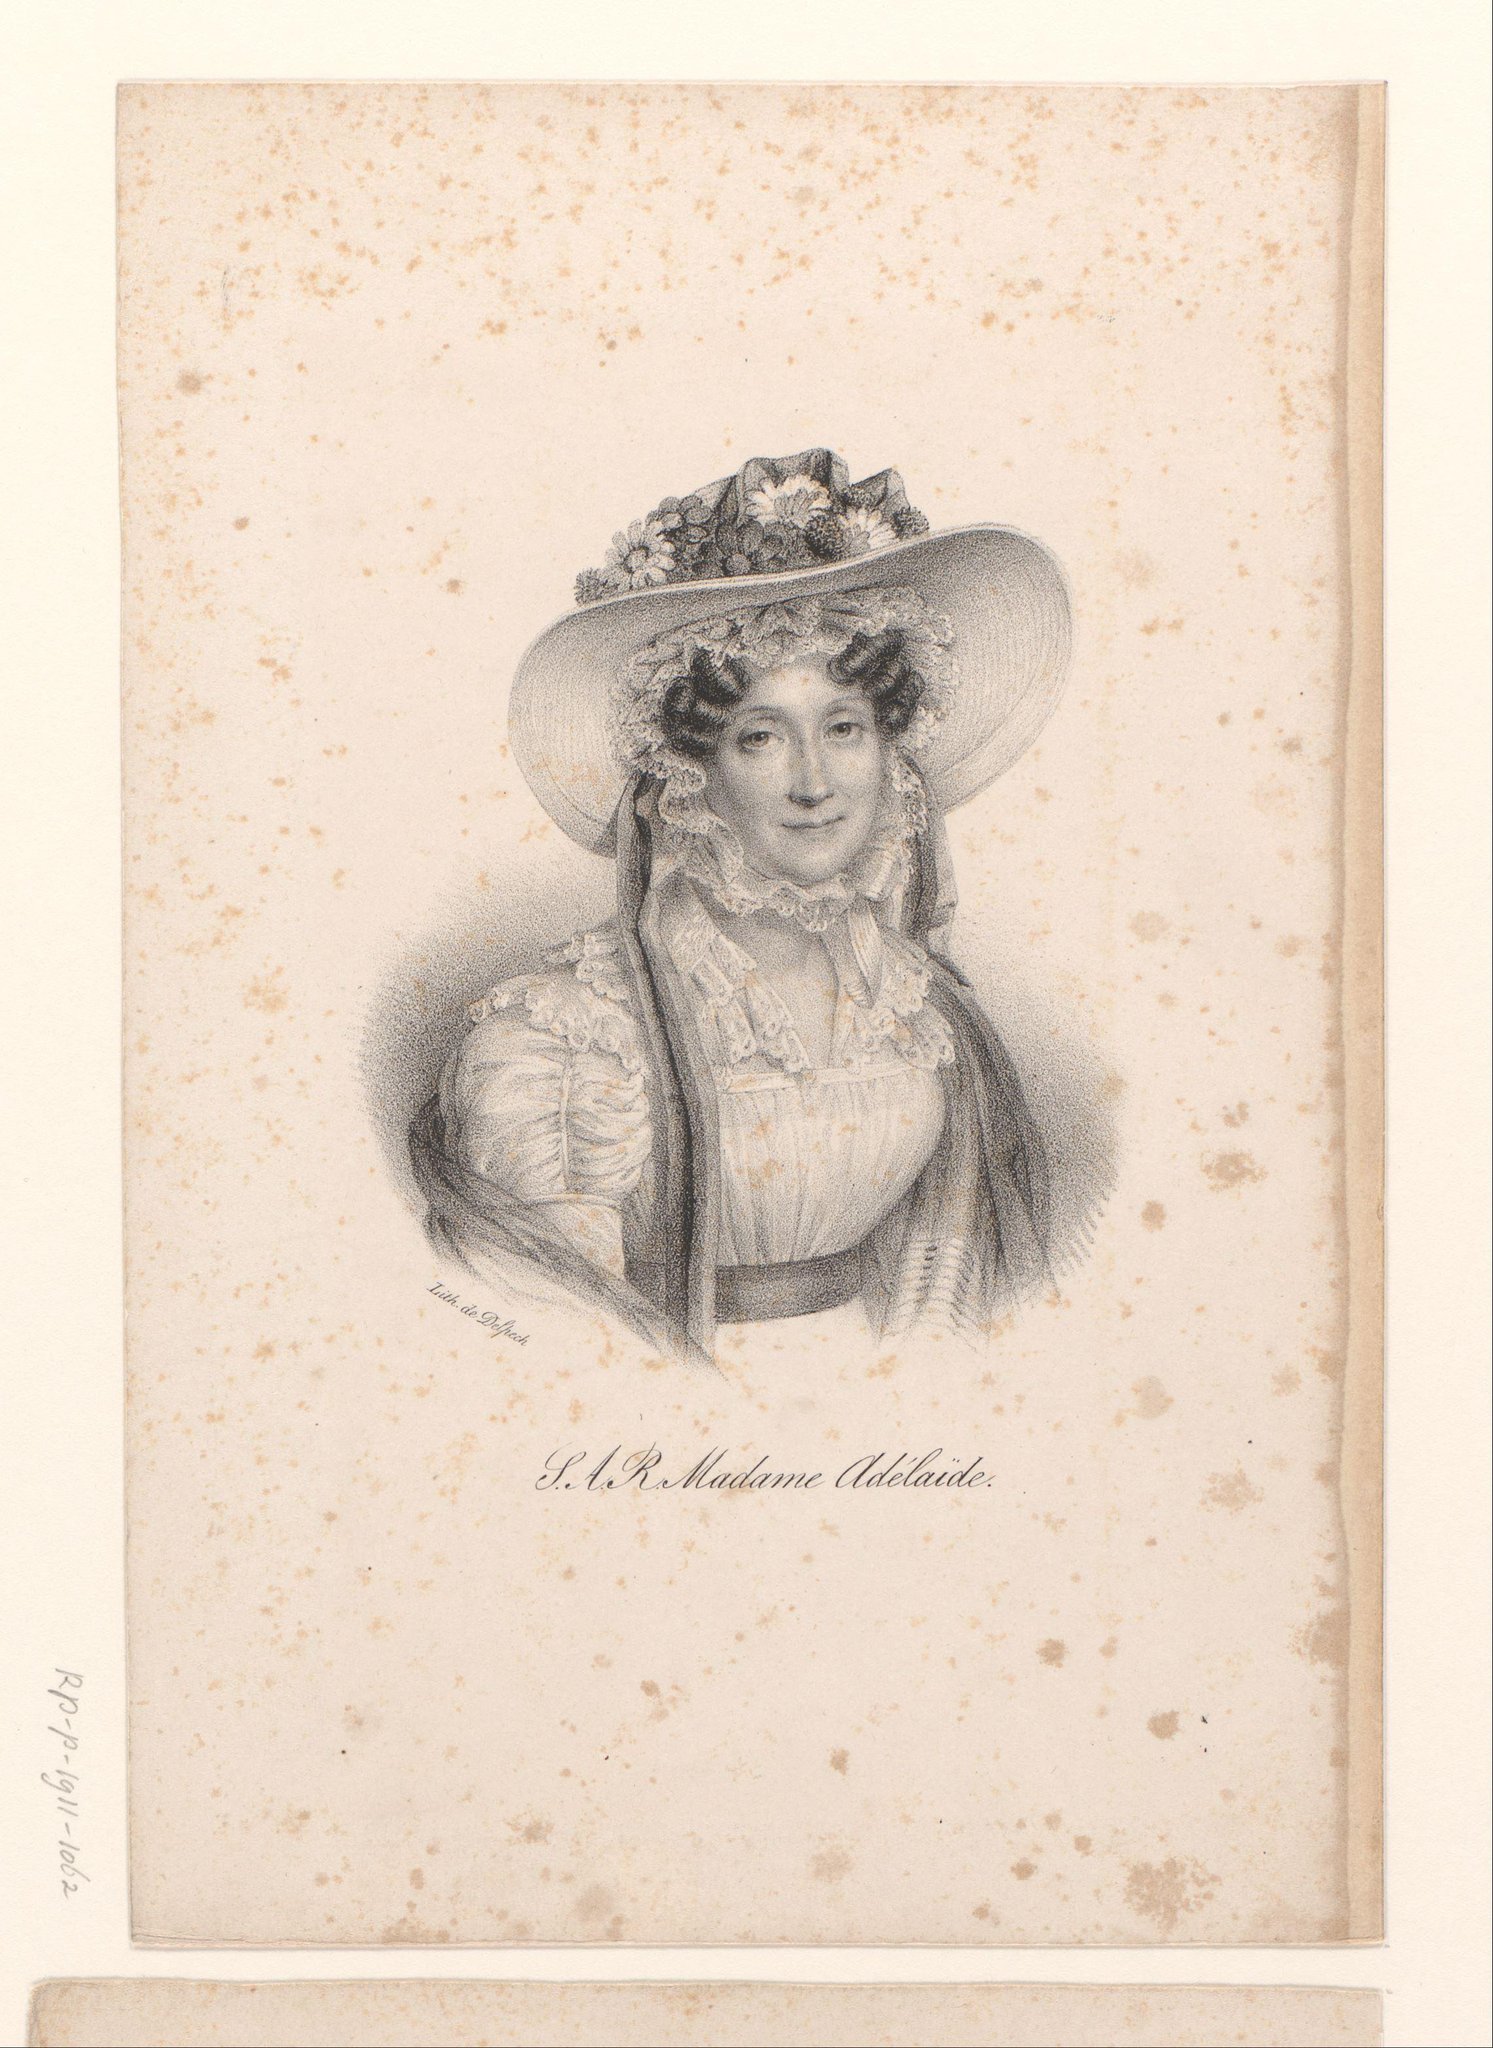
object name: print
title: Portret van prinses Adélaïde d'Orléans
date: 1818-1842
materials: paper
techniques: lithograph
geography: paris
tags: paris, historical persons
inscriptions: collector's mark: Lugt 2228a